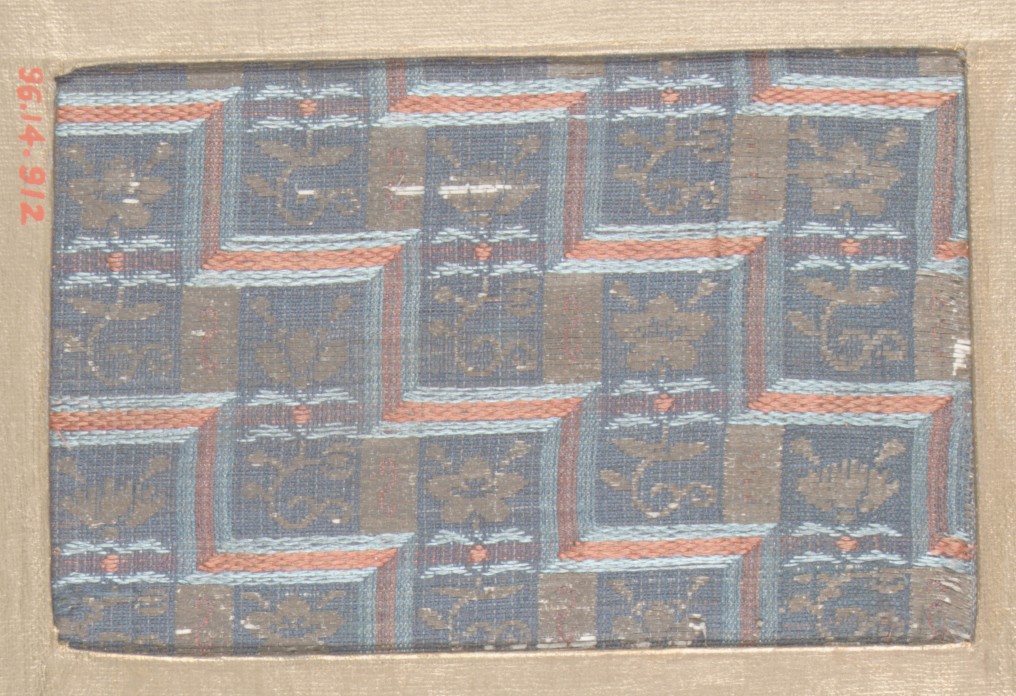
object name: piece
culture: japanese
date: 1701-1900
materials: silk